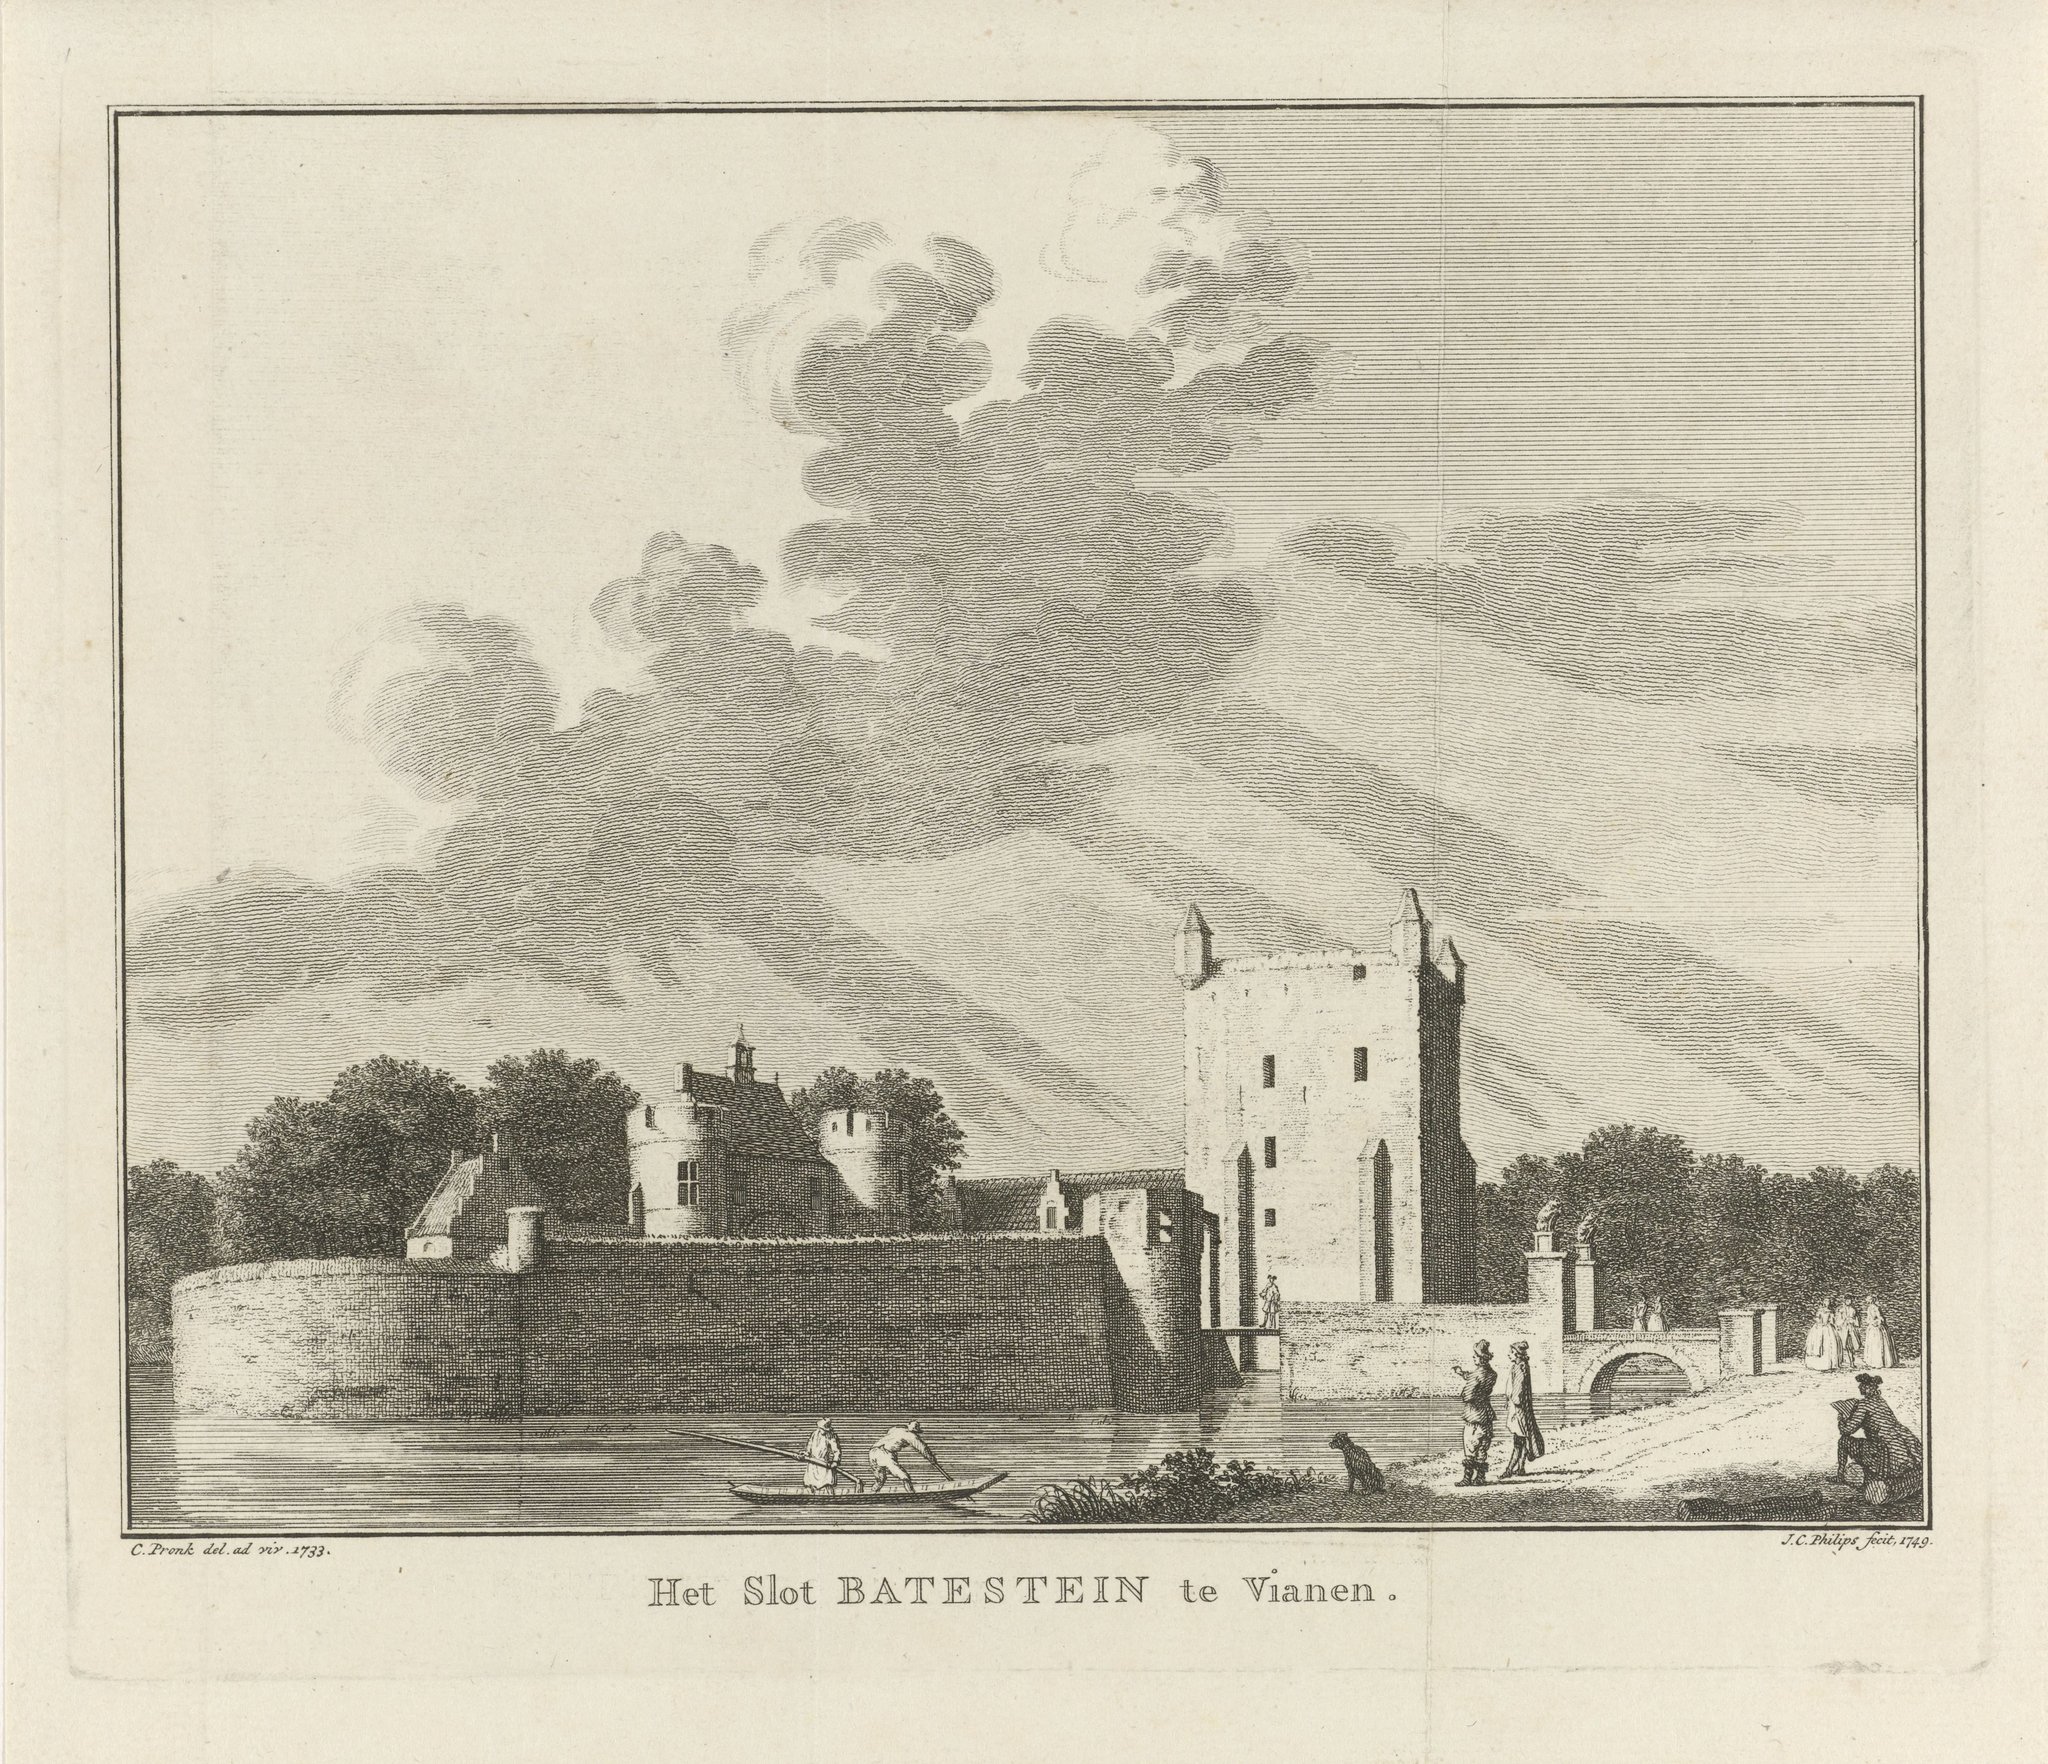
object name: print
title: Gezicht op Kasteel Batestein, 1733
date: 1749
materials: paper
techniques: etching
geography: netherlands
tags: castle, rowing-boat, canoe, etc.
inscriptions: collector's mark: Lugt 2228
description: Gezicht op Kasteel Batestein te Vianen, in de situatie omstreeks 1733. Op de voorgrond twee mannen in een roeiboot op de slotgracht.